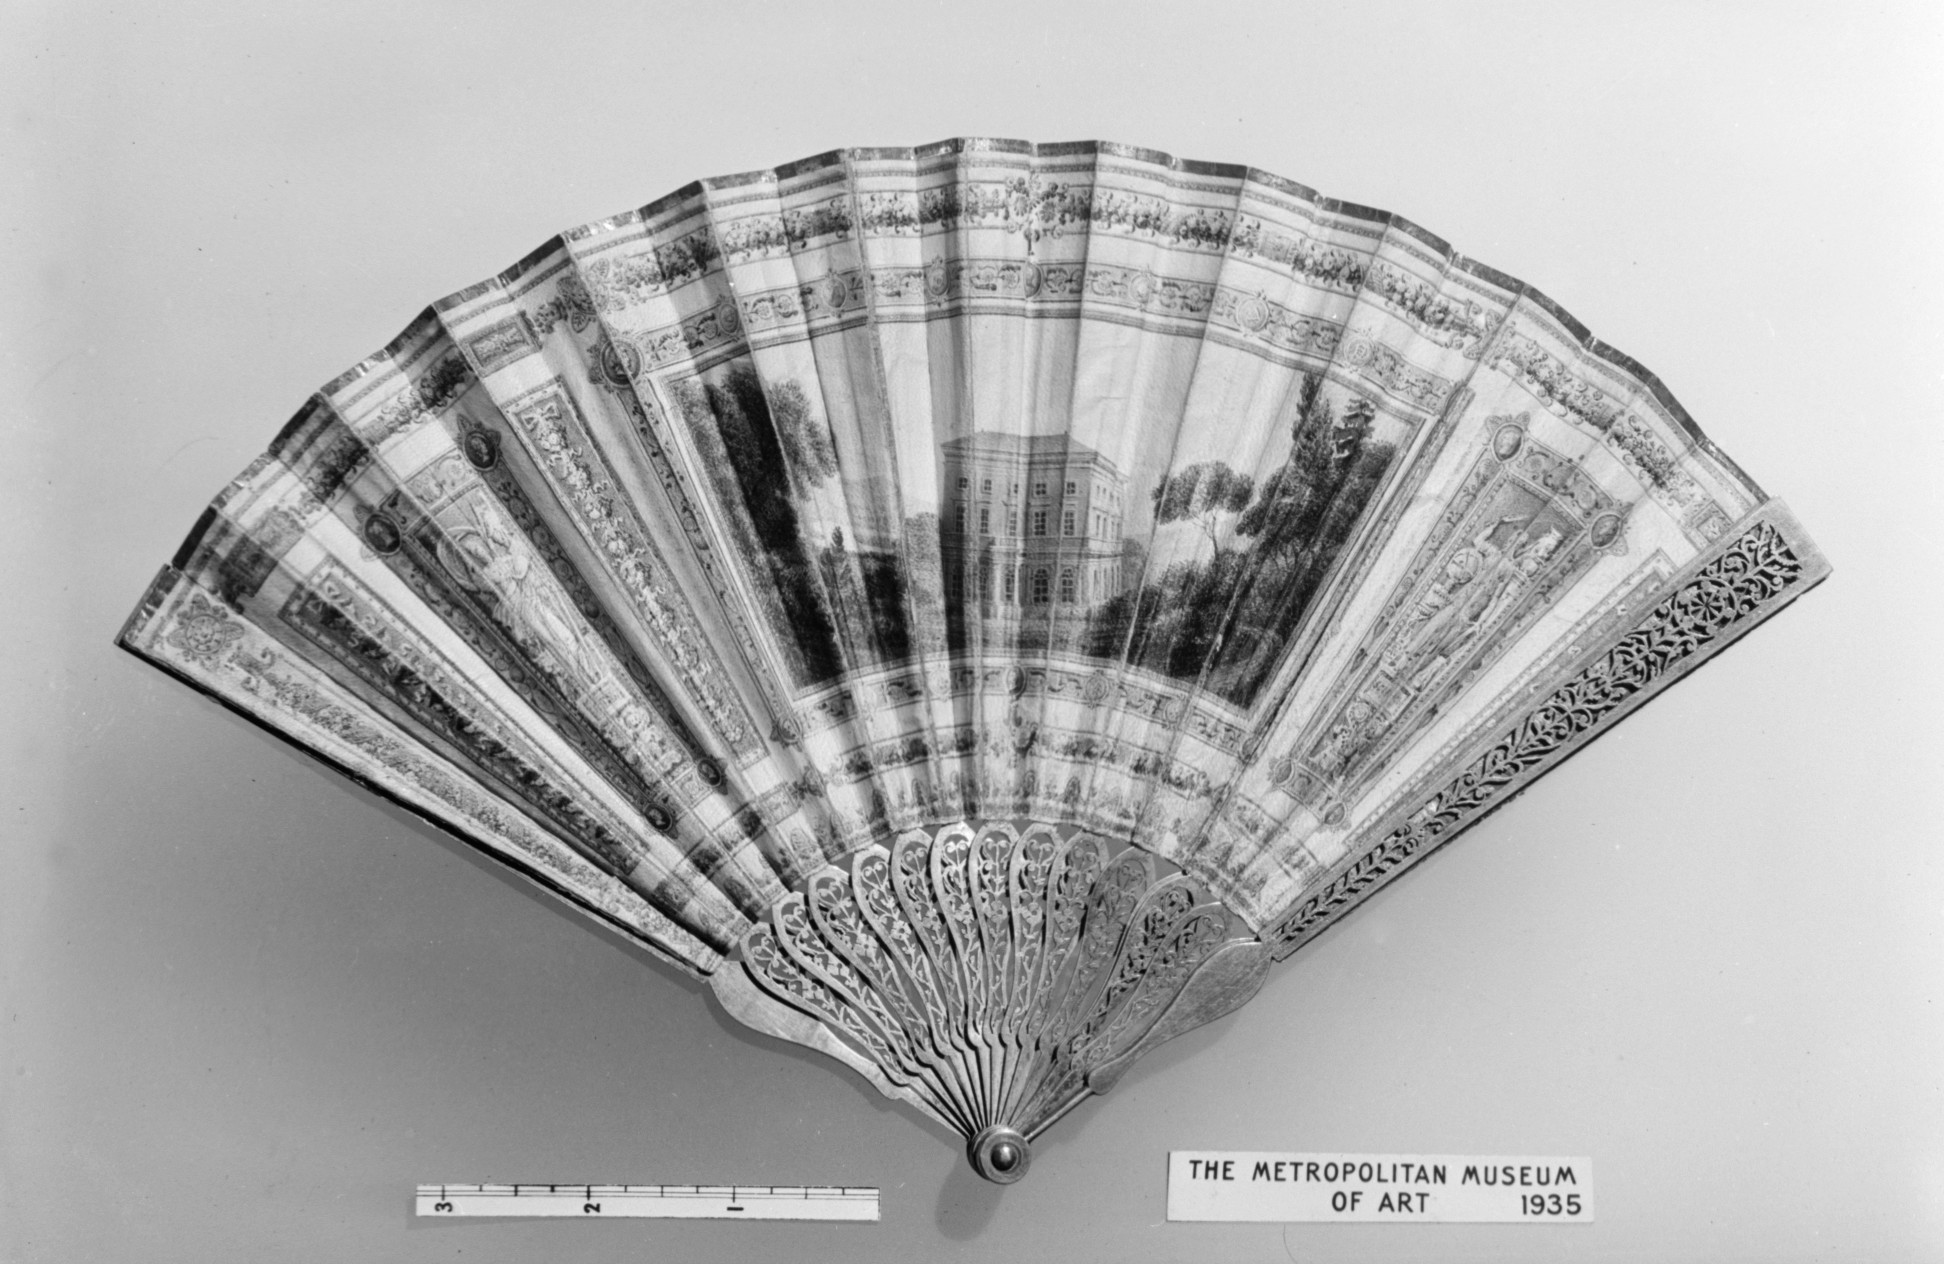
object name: fan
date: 1801-1833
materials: brass, skin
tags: buildings